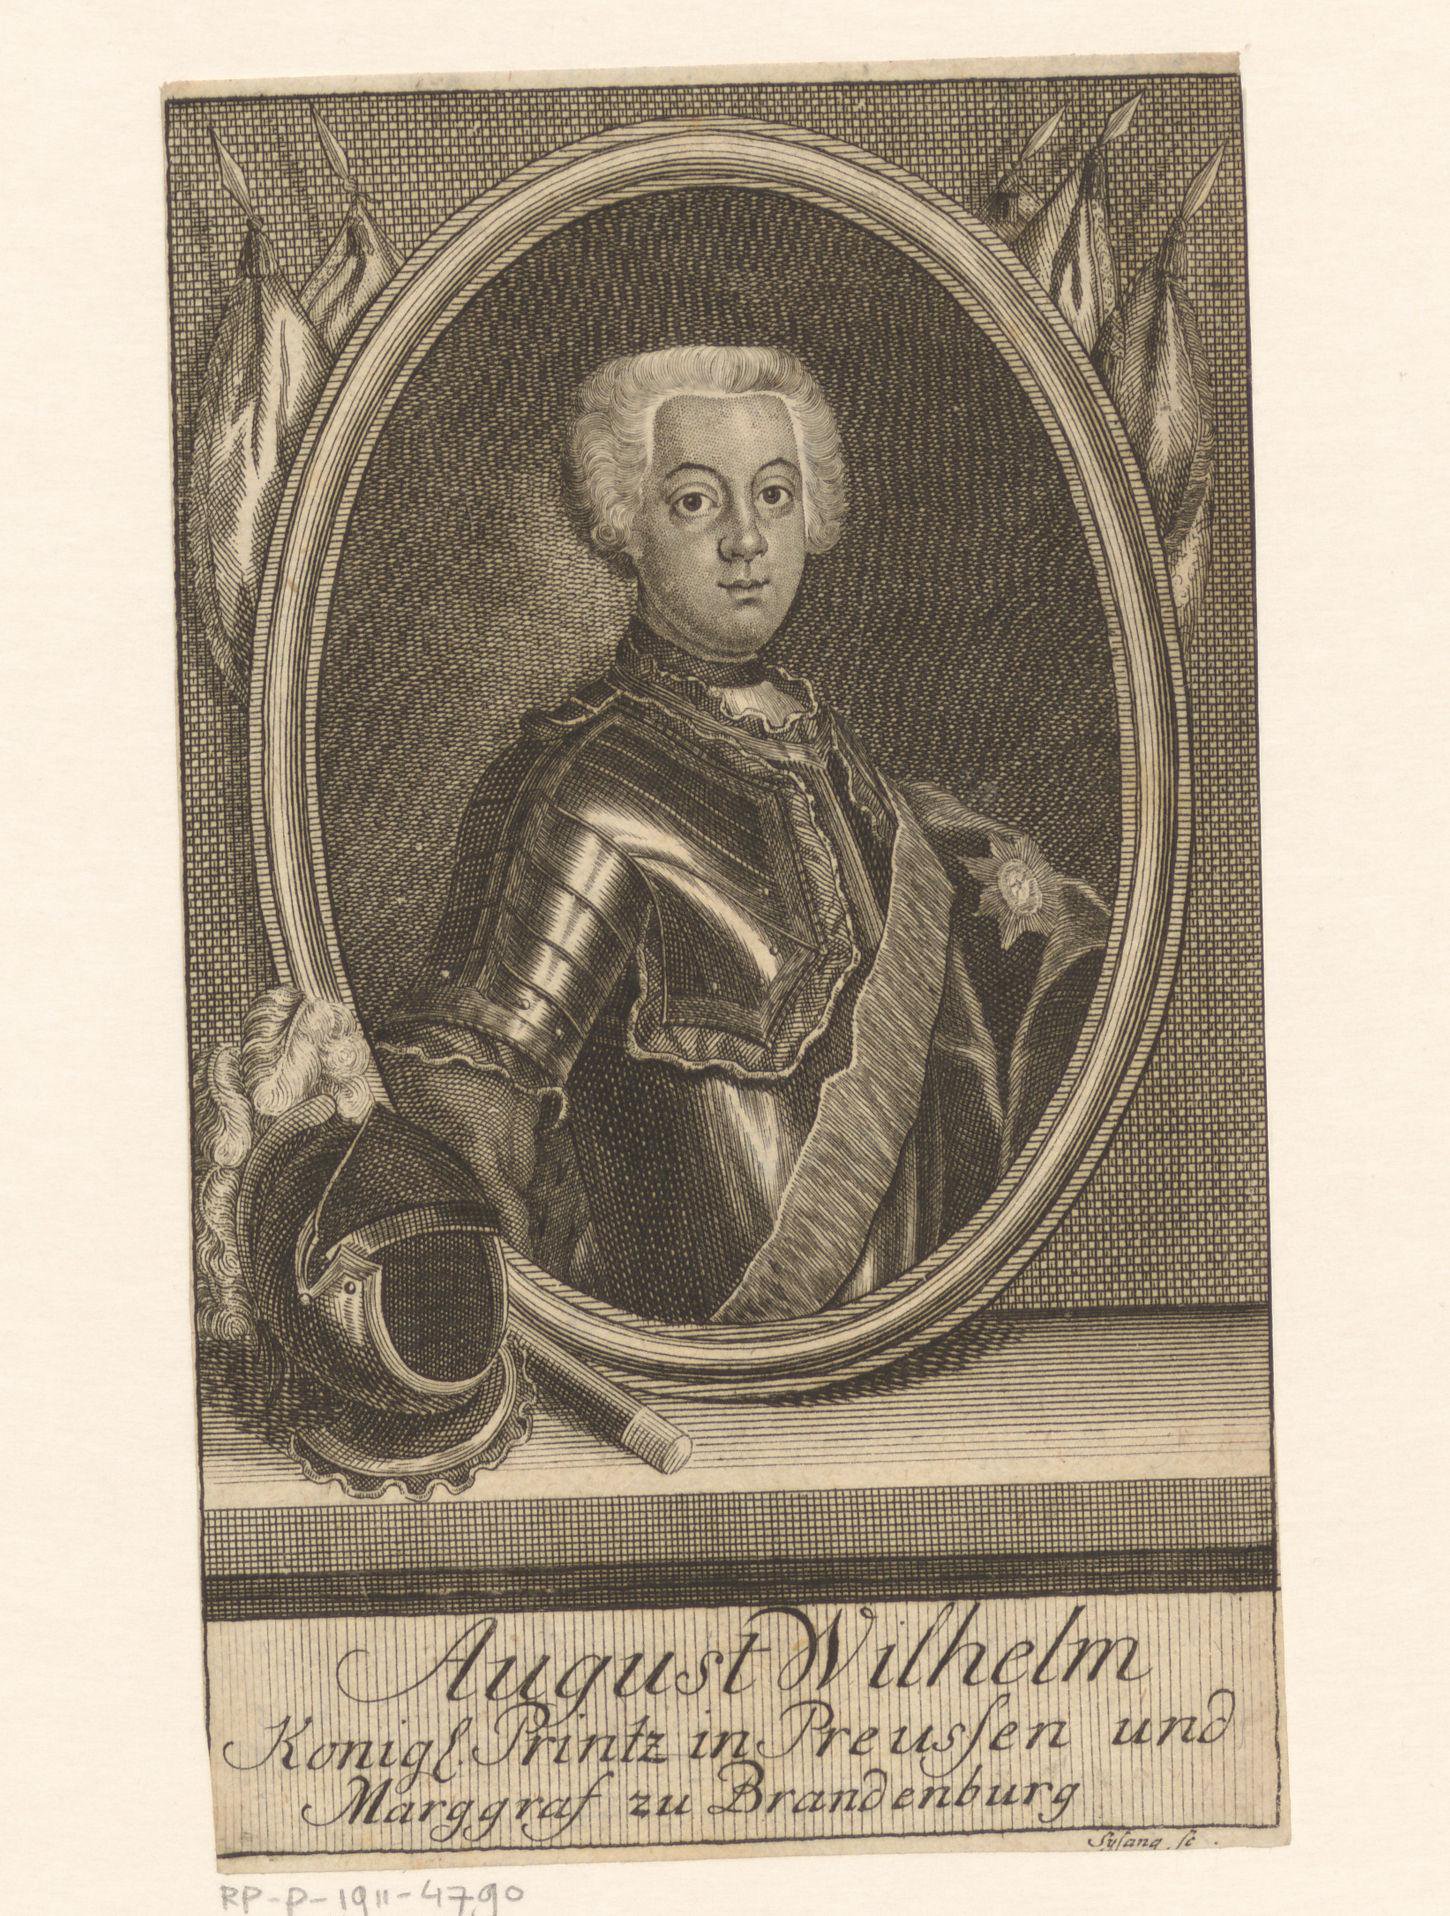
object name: print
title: Portret van August Willem, prins van Pruisen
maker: johann christoph sysang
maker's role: print maker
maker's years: 1703-1757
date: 1740-1757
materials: paper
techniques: engraving, etching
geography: germany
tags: helmet, armour, historical persons, baton of general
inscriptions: collector's mark: Lugt 2228